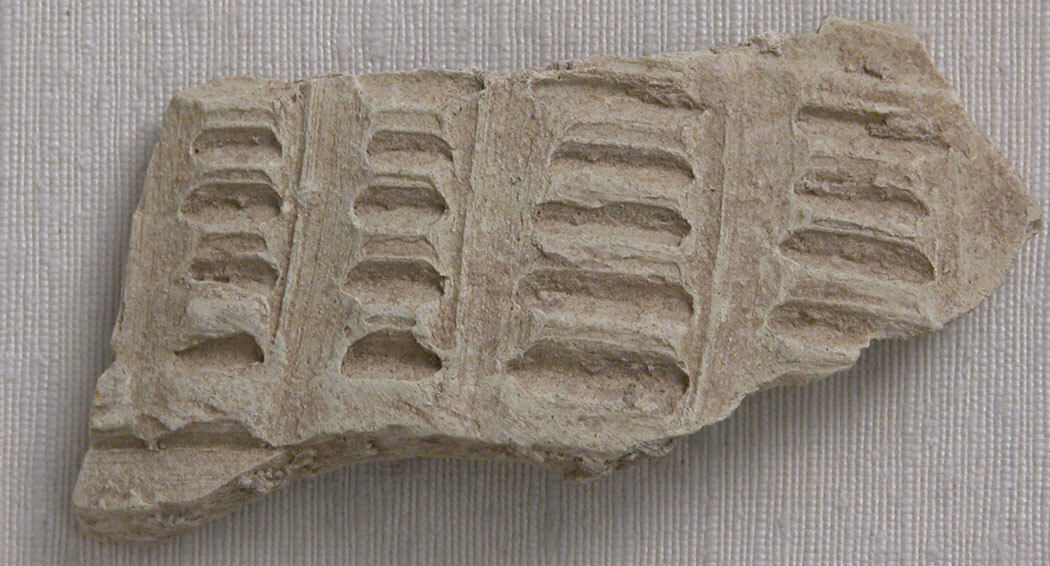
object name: fragment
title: Ceramic Fragment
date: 701-900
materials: earthenware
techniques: stamping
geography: iraq